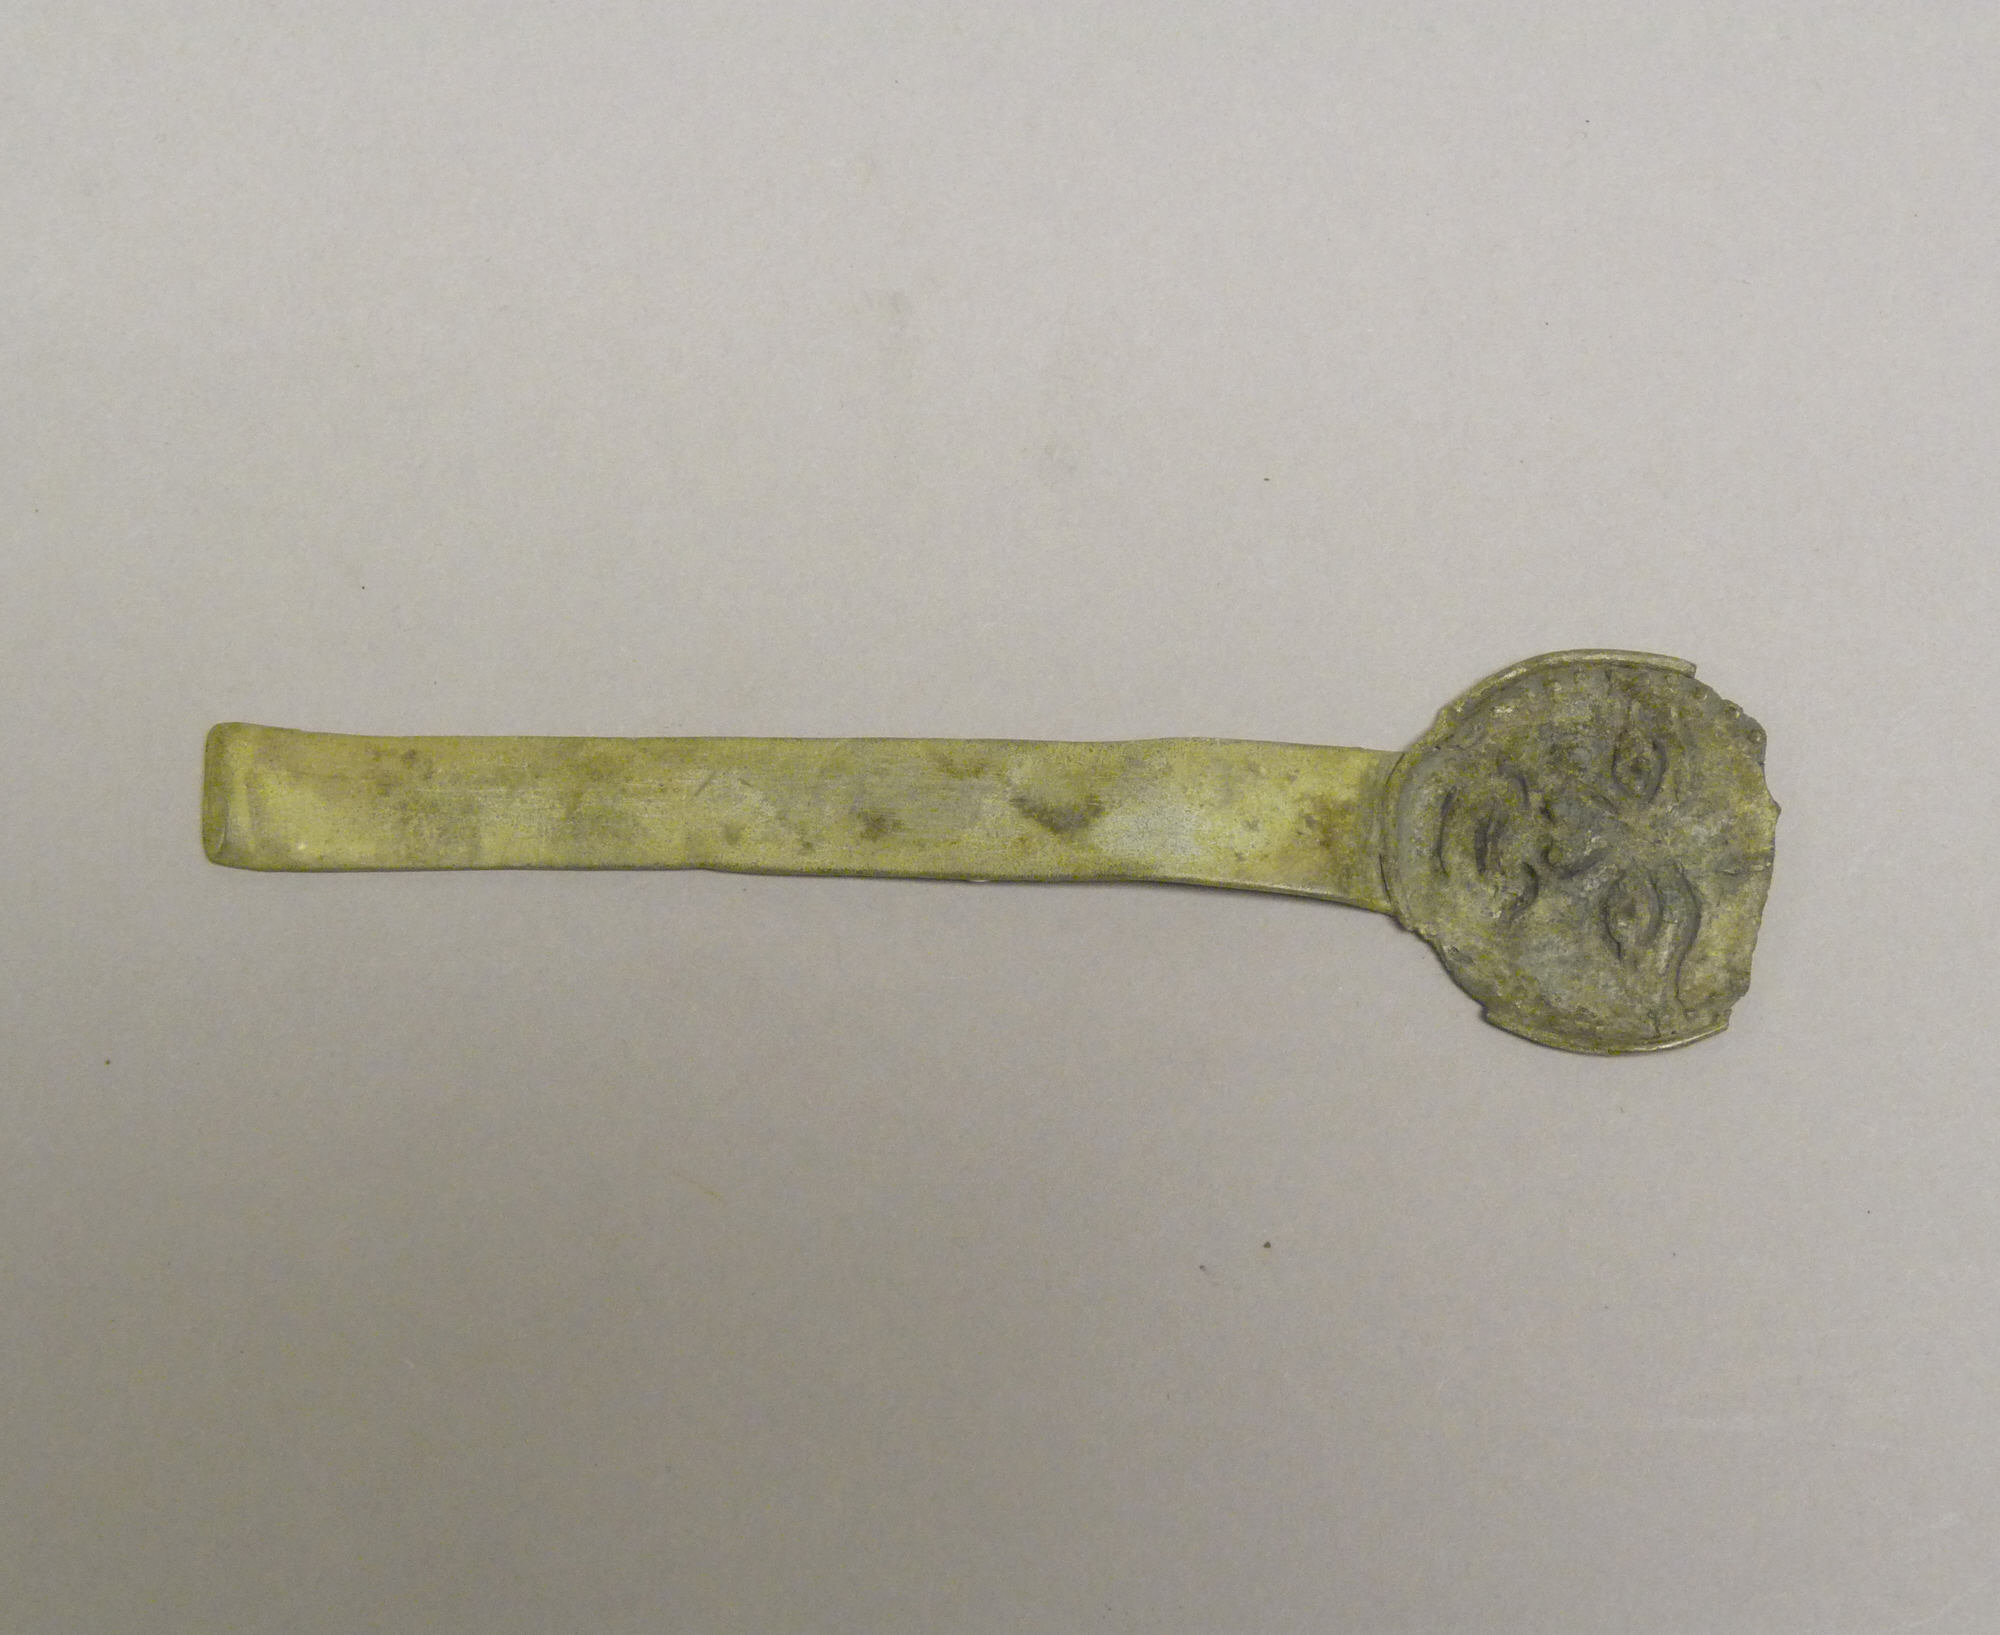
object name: implement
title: Implement with Face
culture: indonesian, javanese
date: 500 BCE-300 CE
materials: bronze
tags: faces